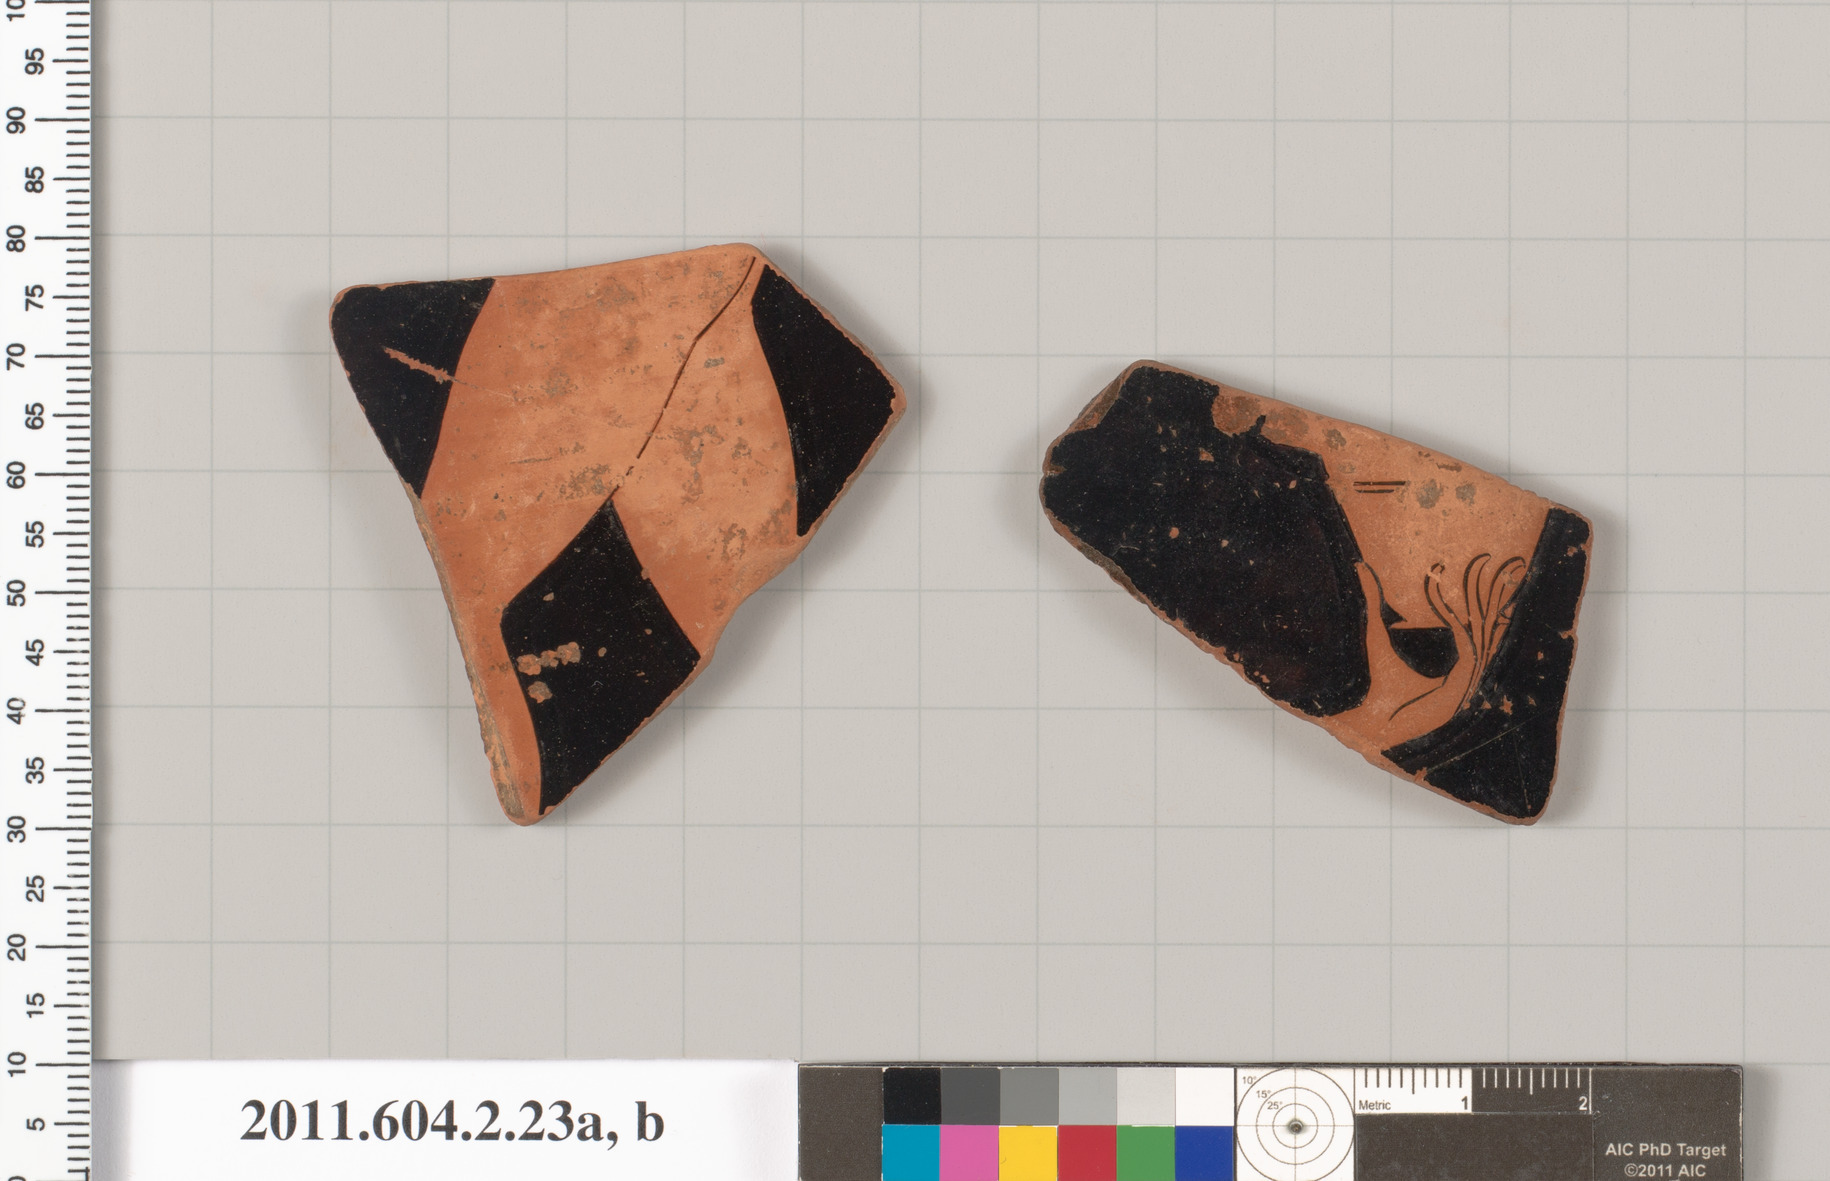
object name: psykter fragment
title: Terracotta fragments of a psykter (vase for cooling wine)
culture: greek, attic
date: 520-500 BCE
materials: terracotta